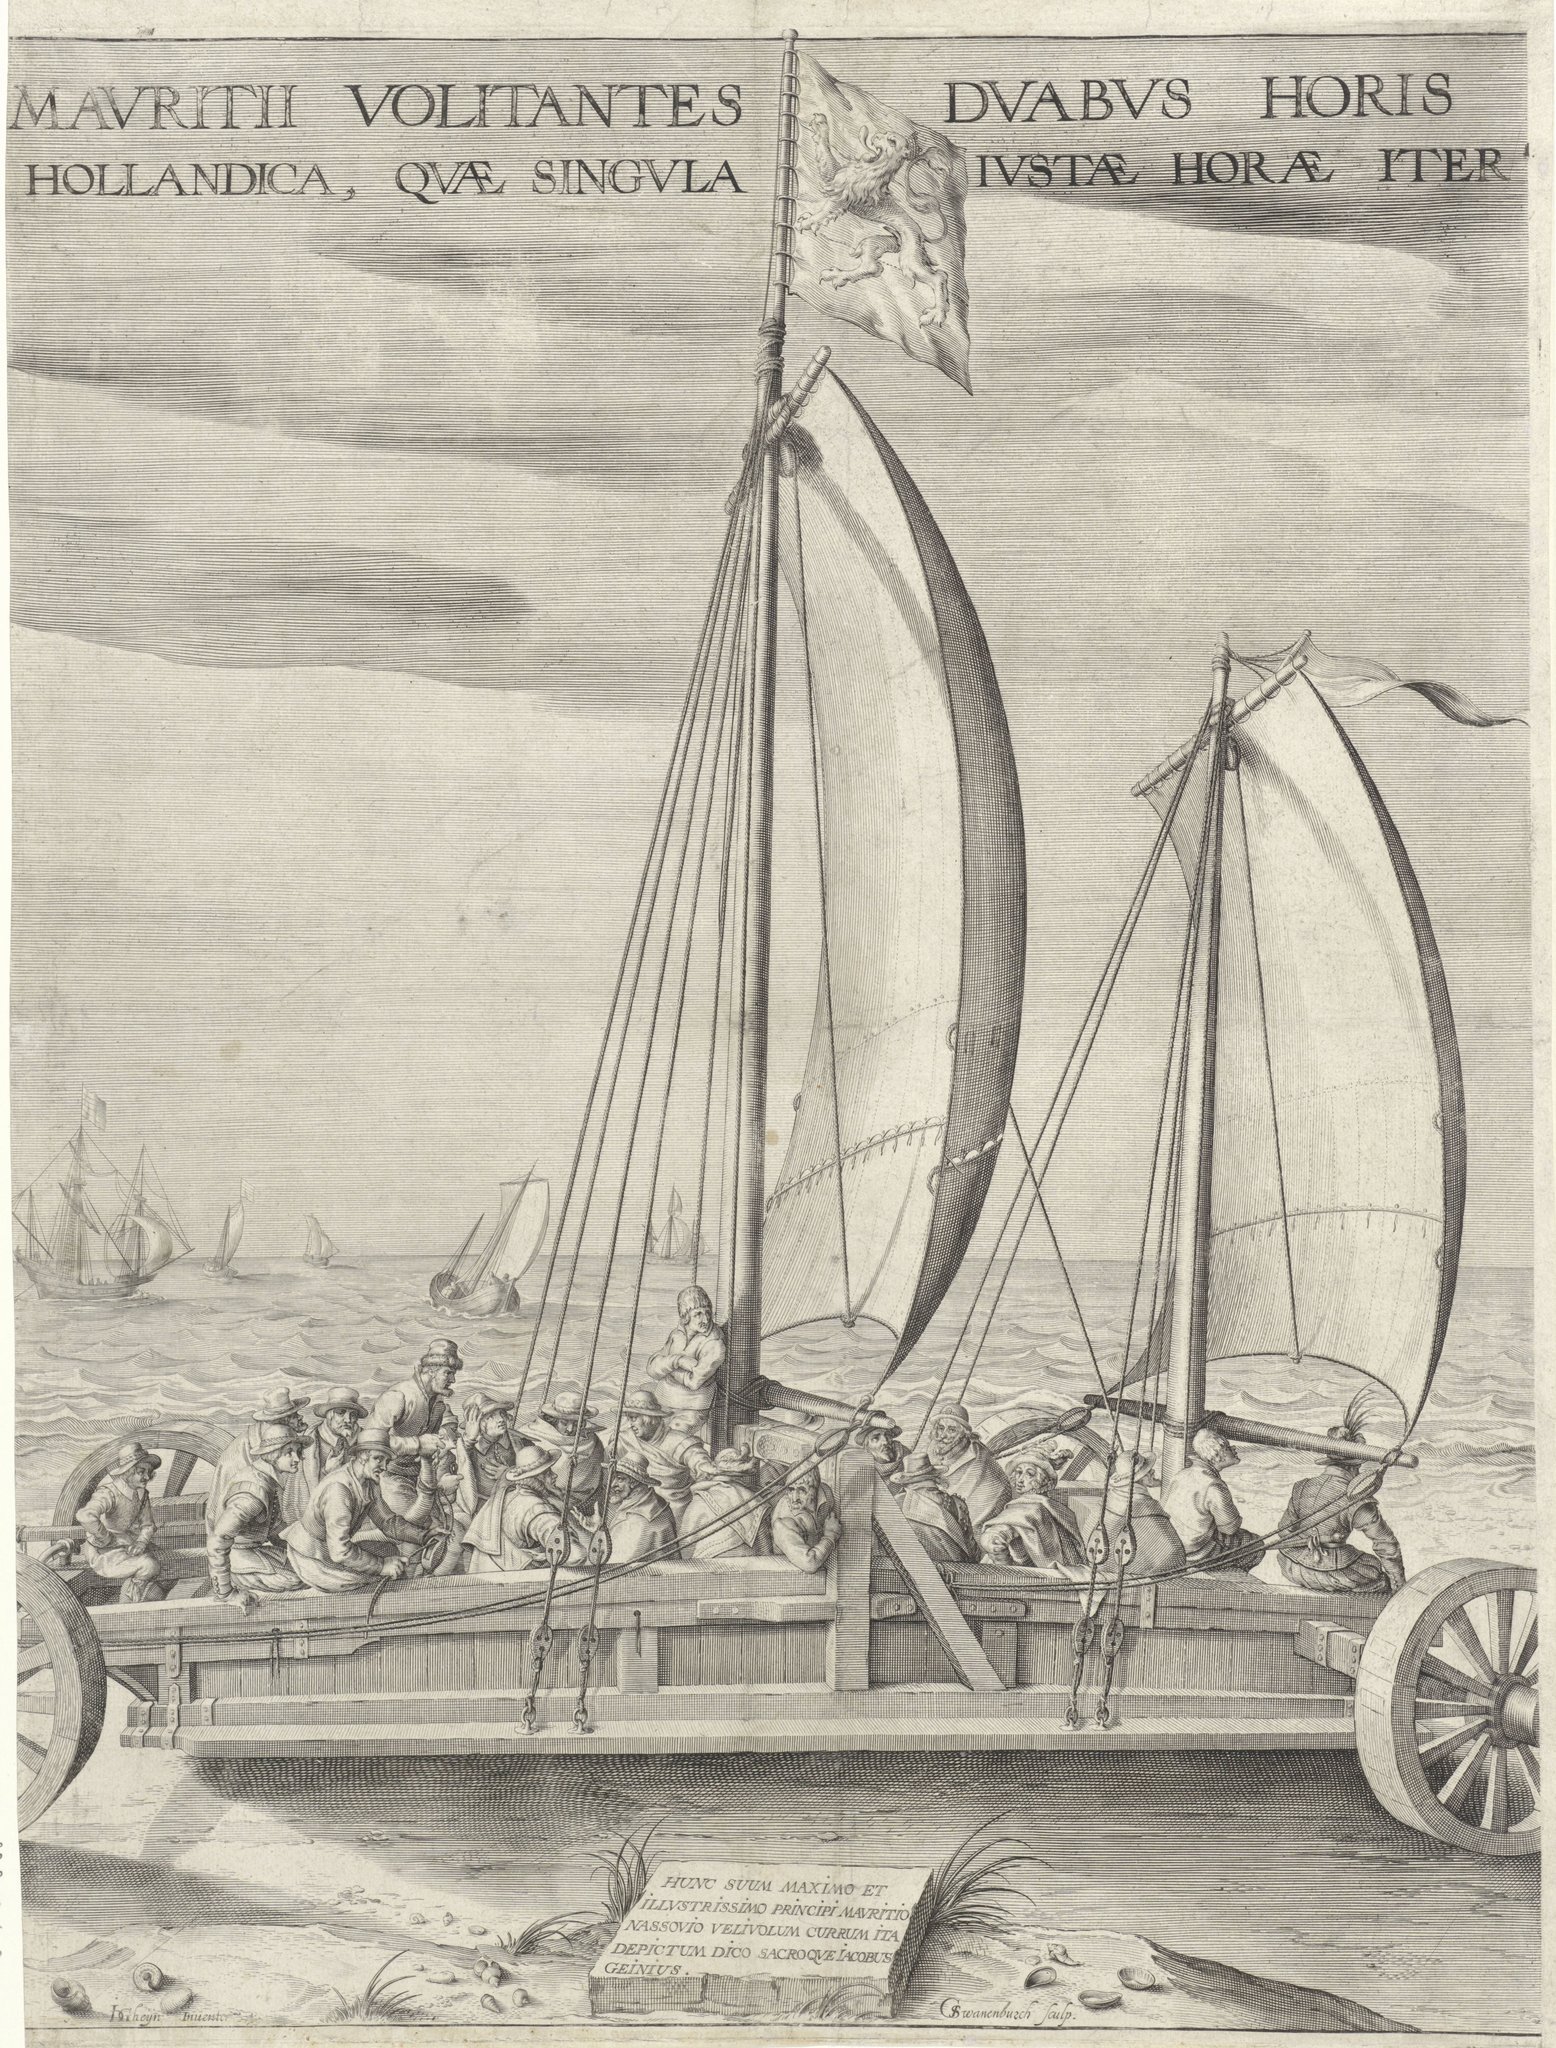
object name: print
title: De zeilwagen van Simon Stevin (middenplaat), 1602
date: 1603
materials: paper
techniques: engraving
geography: leiden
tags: maurice (prince of orange), bruges, simon stevin, sailing-car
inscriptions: collector's mark: Lugt 2228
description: De zeilwagen van Simon Stevin (middenplaat), 1602. Prins Maurits maakt samen met een groep vrienden een tocht over het strand van Scheveningen naar Petten in de zeilwagen gebouwd door Simon Stevin, april-mei 1602. De prins zit tussen zijn vrienden in de wagen. Op de voorgrond een stenen tablet met opschrift in het Latijn (de opdracht). Middenplaat van een grote voorstelling bestaande uit drie delen.